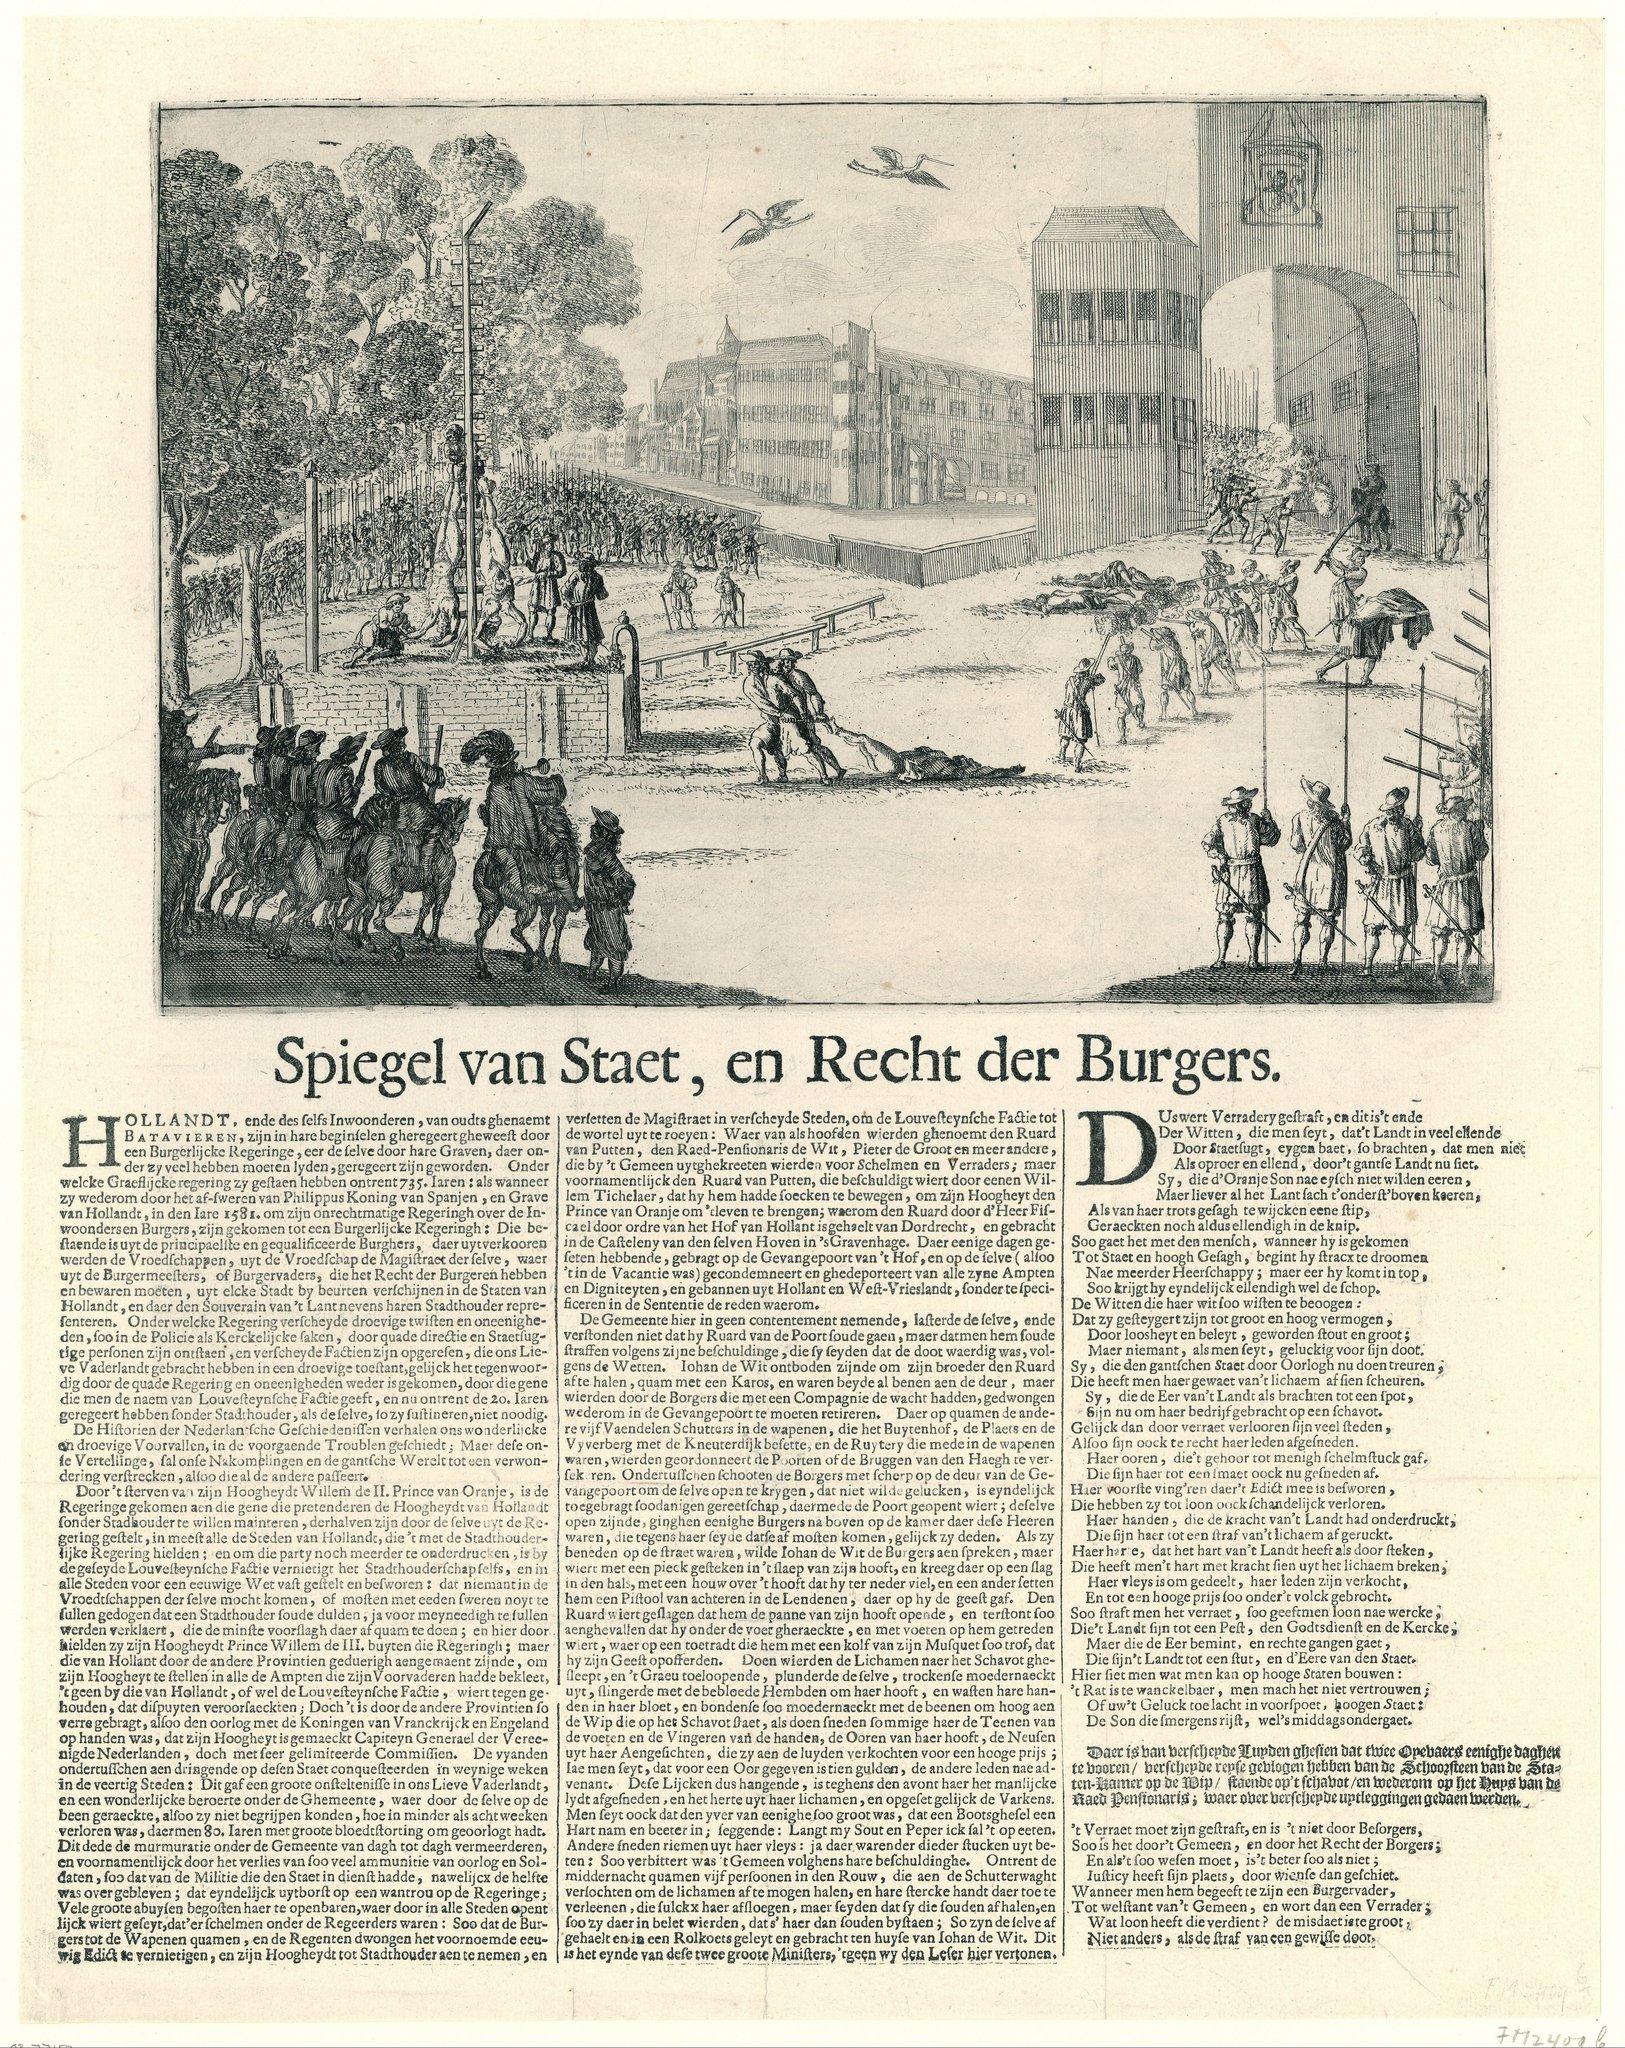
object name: print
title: Spiegel van Staet, en Recht der Burgers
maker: Anonymous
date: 1672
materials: paper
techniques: etching, letterpress printing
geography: northern netherlands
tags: dordrecht, the hague, cornelis de witt, politician, johan de witt, mutilation of the corpse, lynching, attempt, political murder, violent death, being killed; being mishandled and maltreated; seeking death (+ death by lynching)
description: Blad met een voorstelling van de moord op de gebroeders Johan en Cornelis de Witt en de verminking van hun lichamen, 20 augustus 1672. In de lucht twee ooievaars. Onder de voorstelling over drie kolommen een lange tekst met een beschrijving van de gebeurtenissen en een vers waarin de moorden worden gerechtvaardigd. Na het vers wordt de episode met de ooievaars kort beschreven. Dit wordt gevolgd door een tweede vers van acht regels.